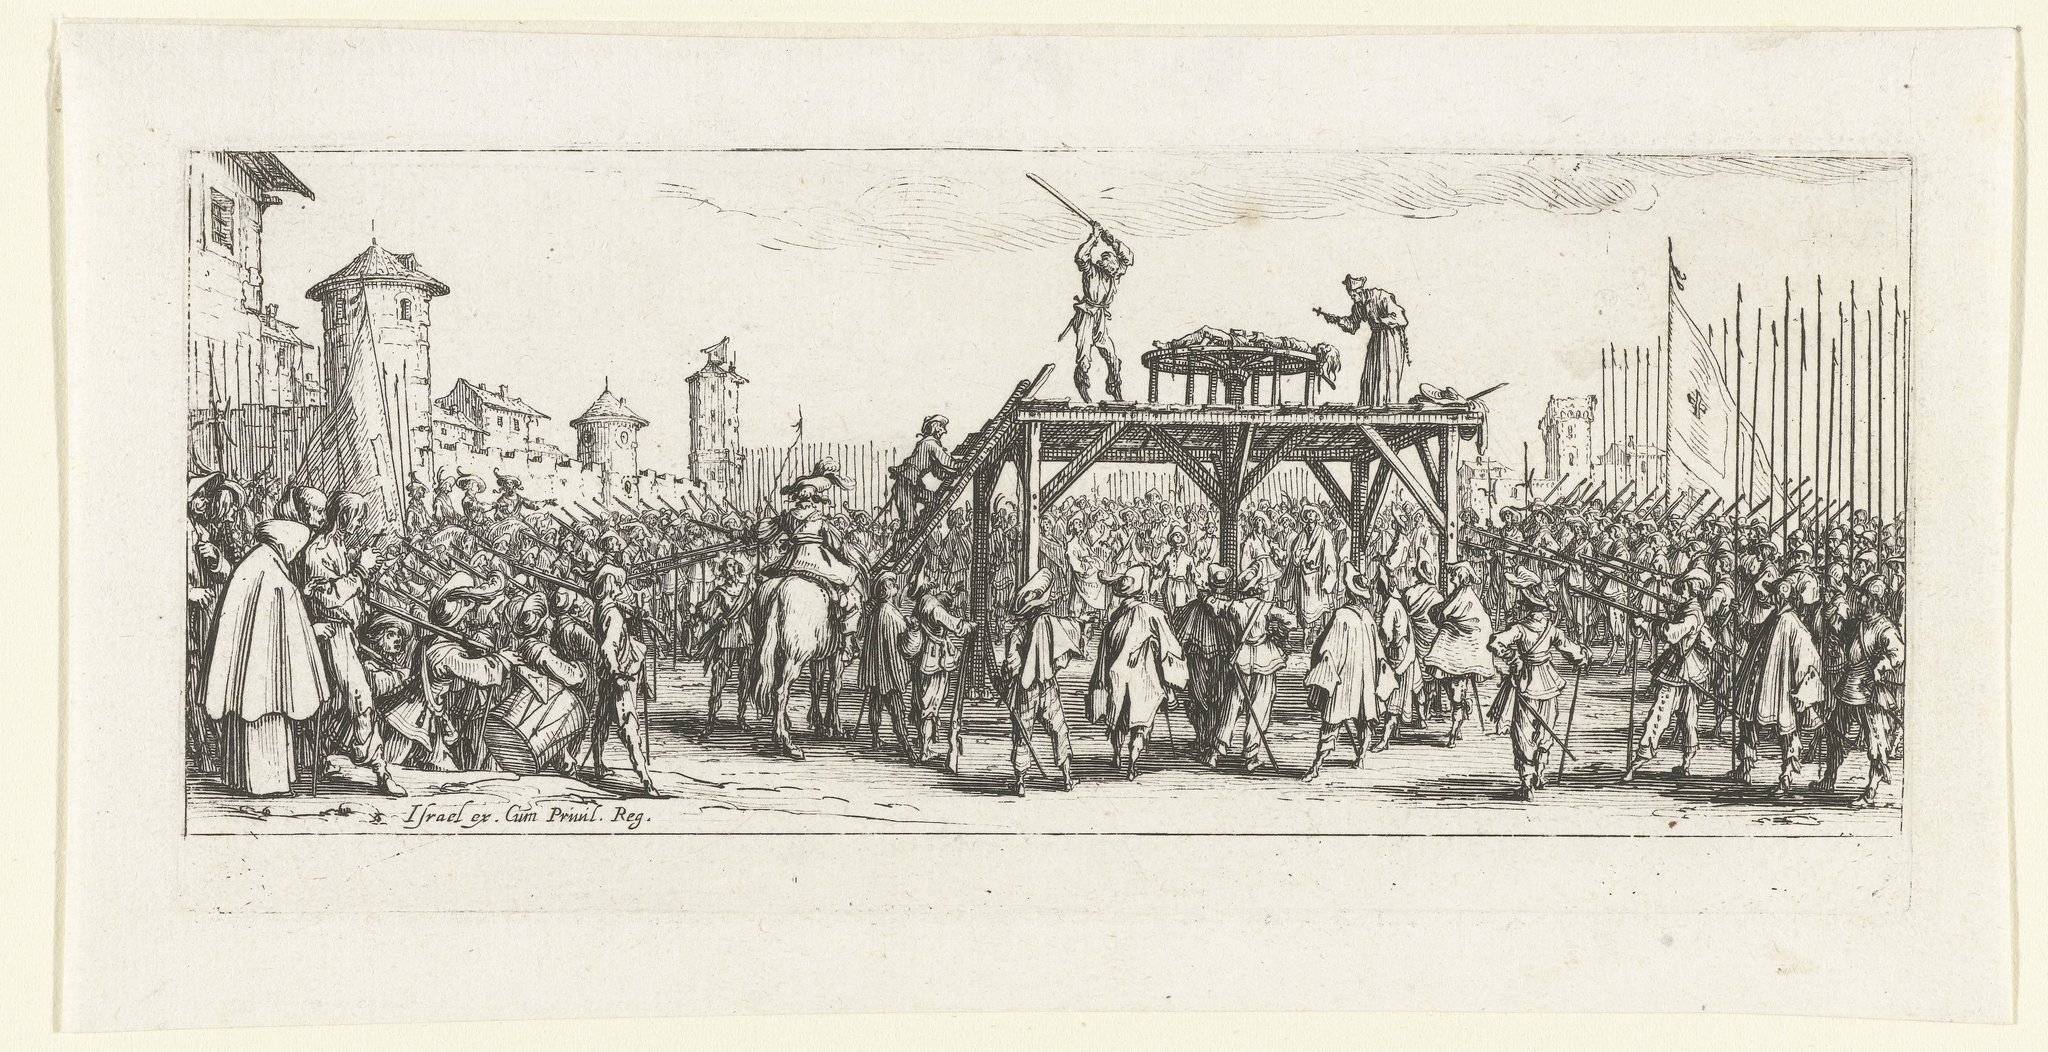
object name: print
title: De gruwelen van de oorlog (groot)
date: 1633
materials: paper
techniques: etching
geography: paris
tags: physical punishment ~ military service, warfare; military affairs (+ outside city-wall or fortress)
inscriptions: collector's mark: Lugt 240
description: Op een open plek bij een stadsmuur zijn vele soldaten verzameld rond een platform waarop een man geradbraakt wordt. Onder de voorstelling een lege marge. Deze prent is onderdeel van een serie van 17 (18 incl. titelprent) prenten met voorstellingen van diverse soorten ellende die oorlogvoering met zich meebrengt.